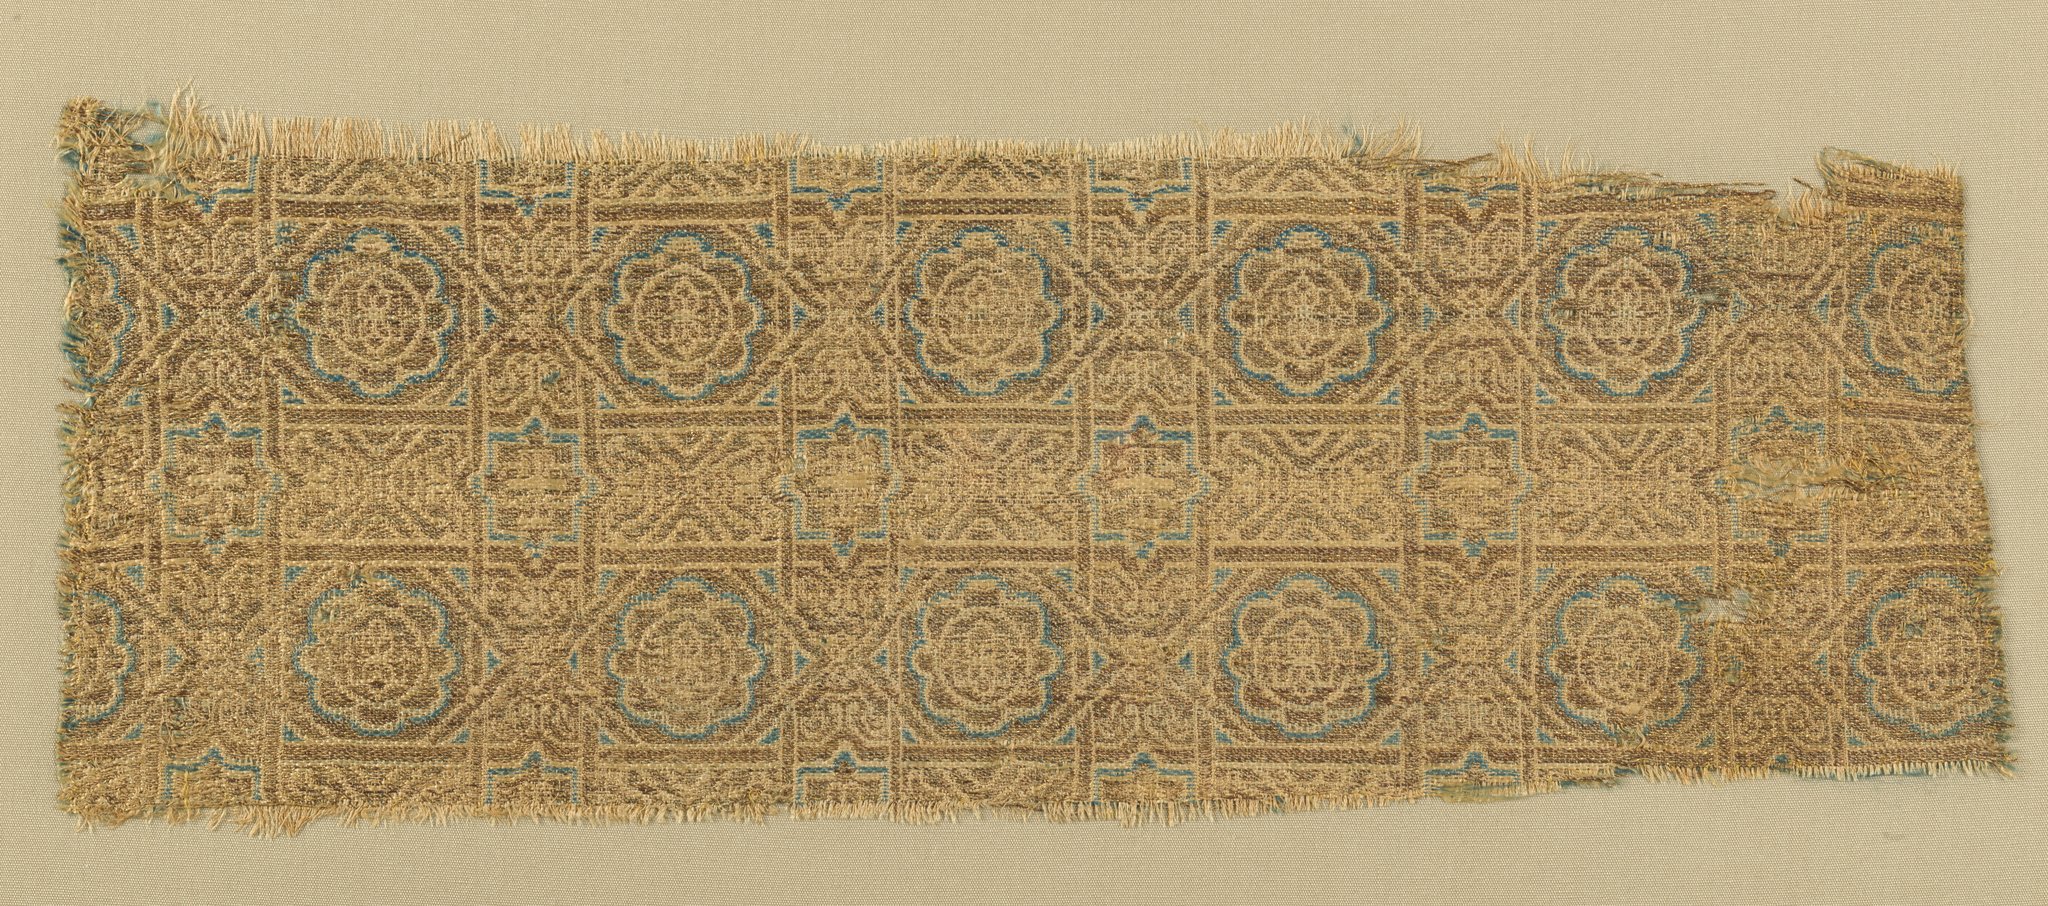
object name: textile fragment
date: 1201-1300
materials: gold, linen, silk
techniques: compound weave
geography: spain